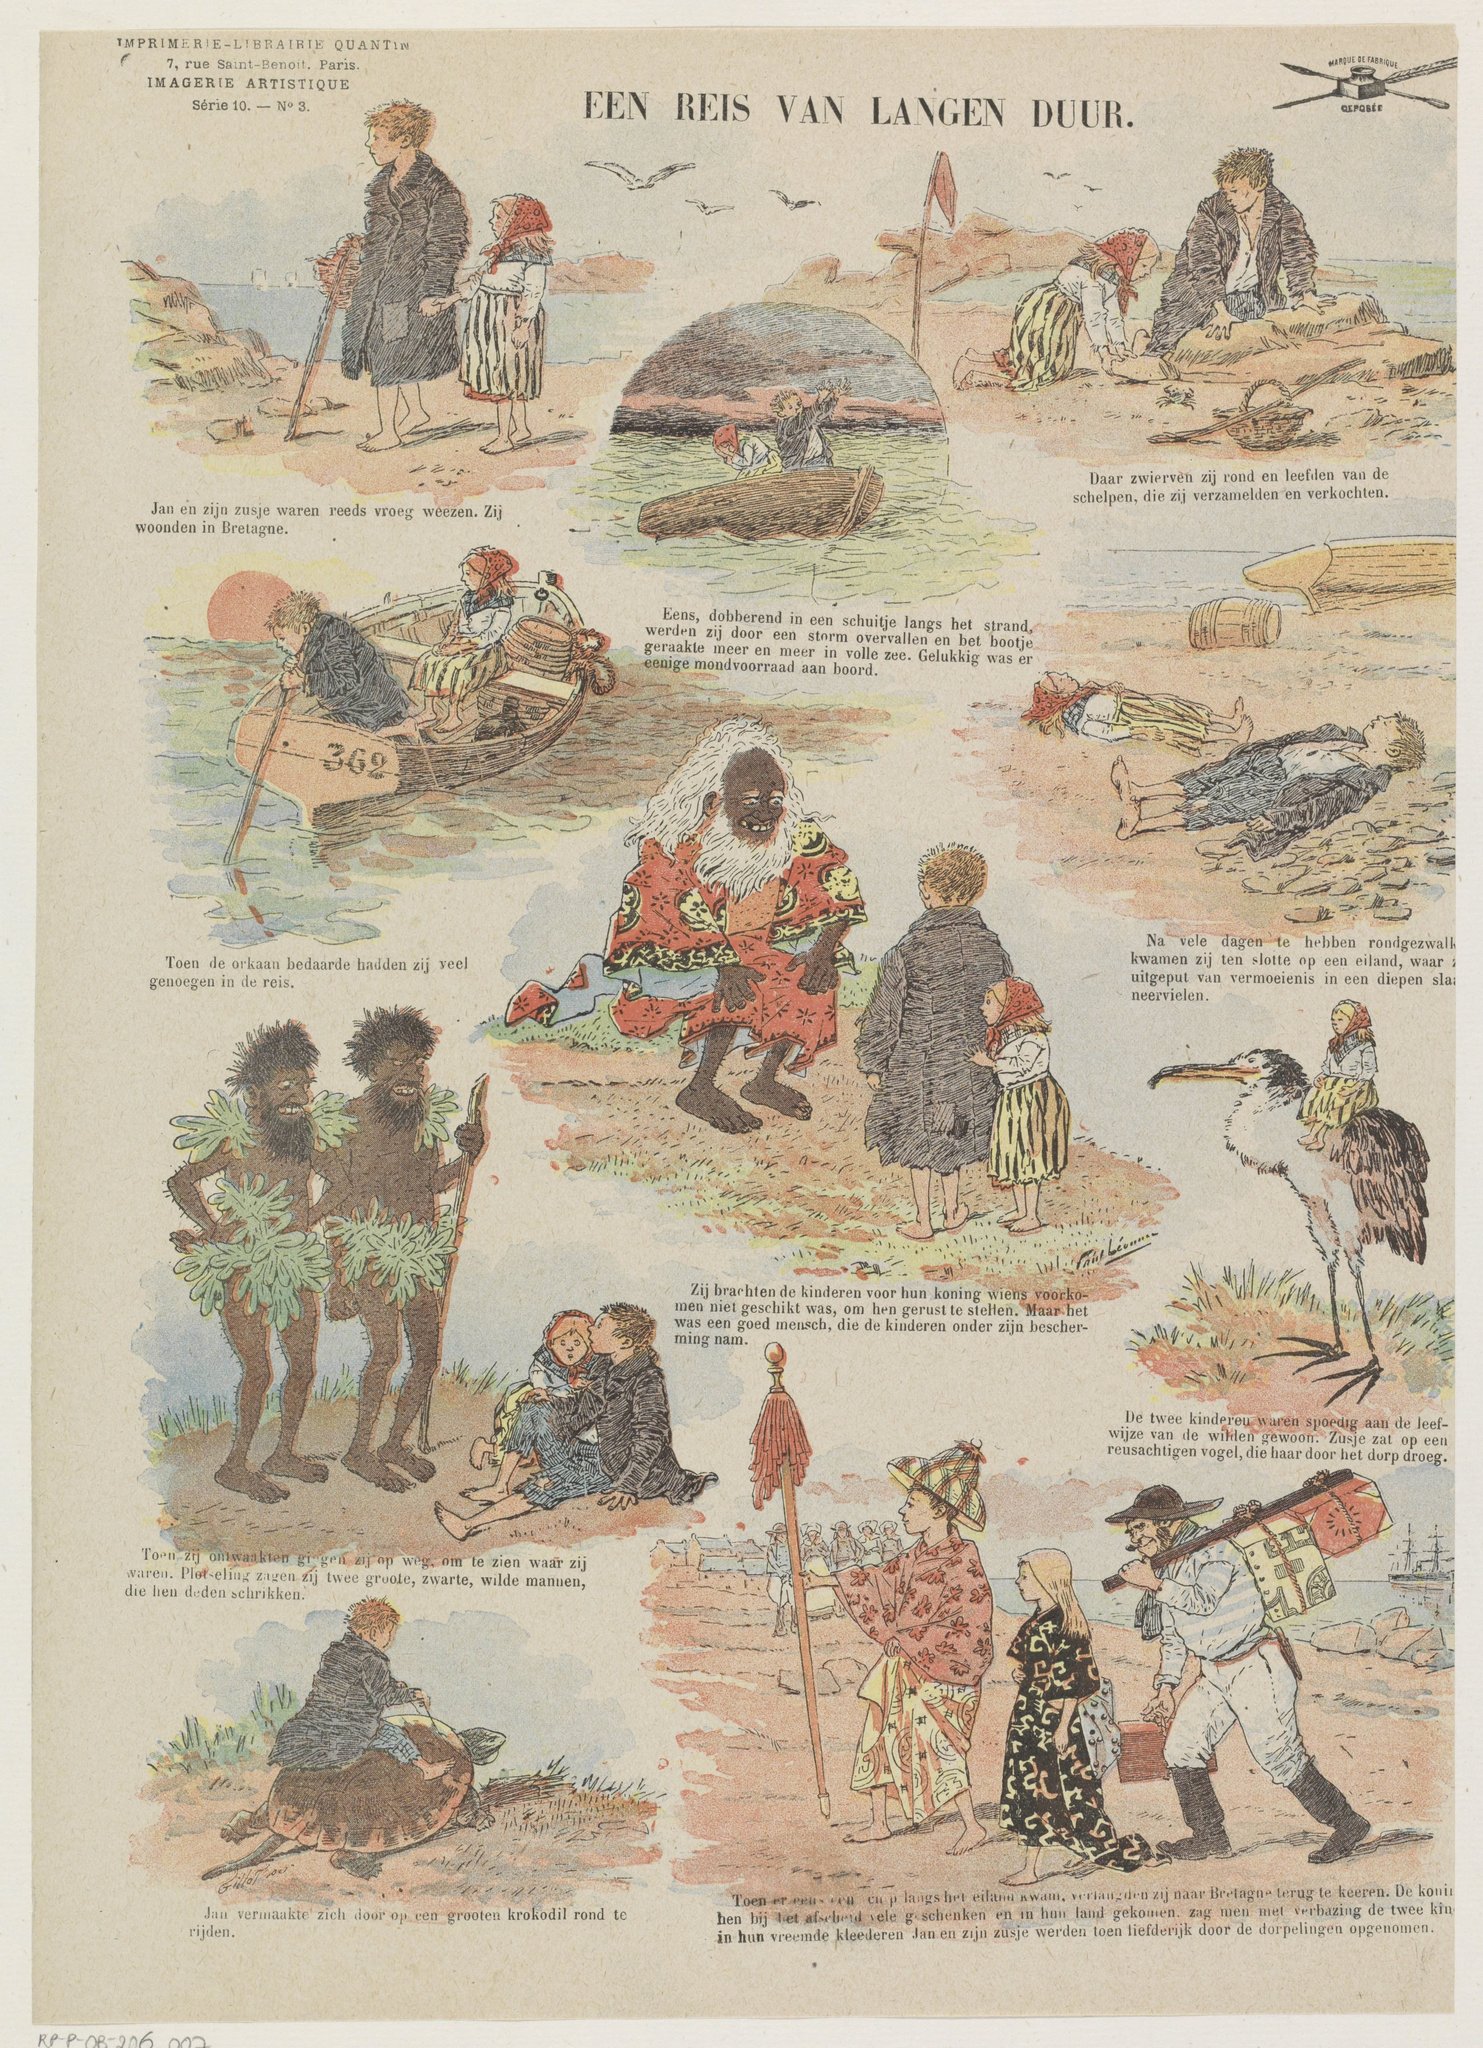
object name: popular print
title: Imagerie Artistique / Série 10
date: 1876-1890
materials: paper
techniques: lithograph, letterpress printing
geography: paris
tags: tortoises, turtles, africans, wreck ashore, tales and fairy tales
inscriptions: collector's mark: Lugt 2760, : ‘marque de fabrique / deposée’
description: Blad met 10 voorstellingen van twee kinderen die aanspoelen op een eiland met wilden. Onder elke afbeelding een onderschrift. Genummerd linksboven: Série 10. - No. 3.